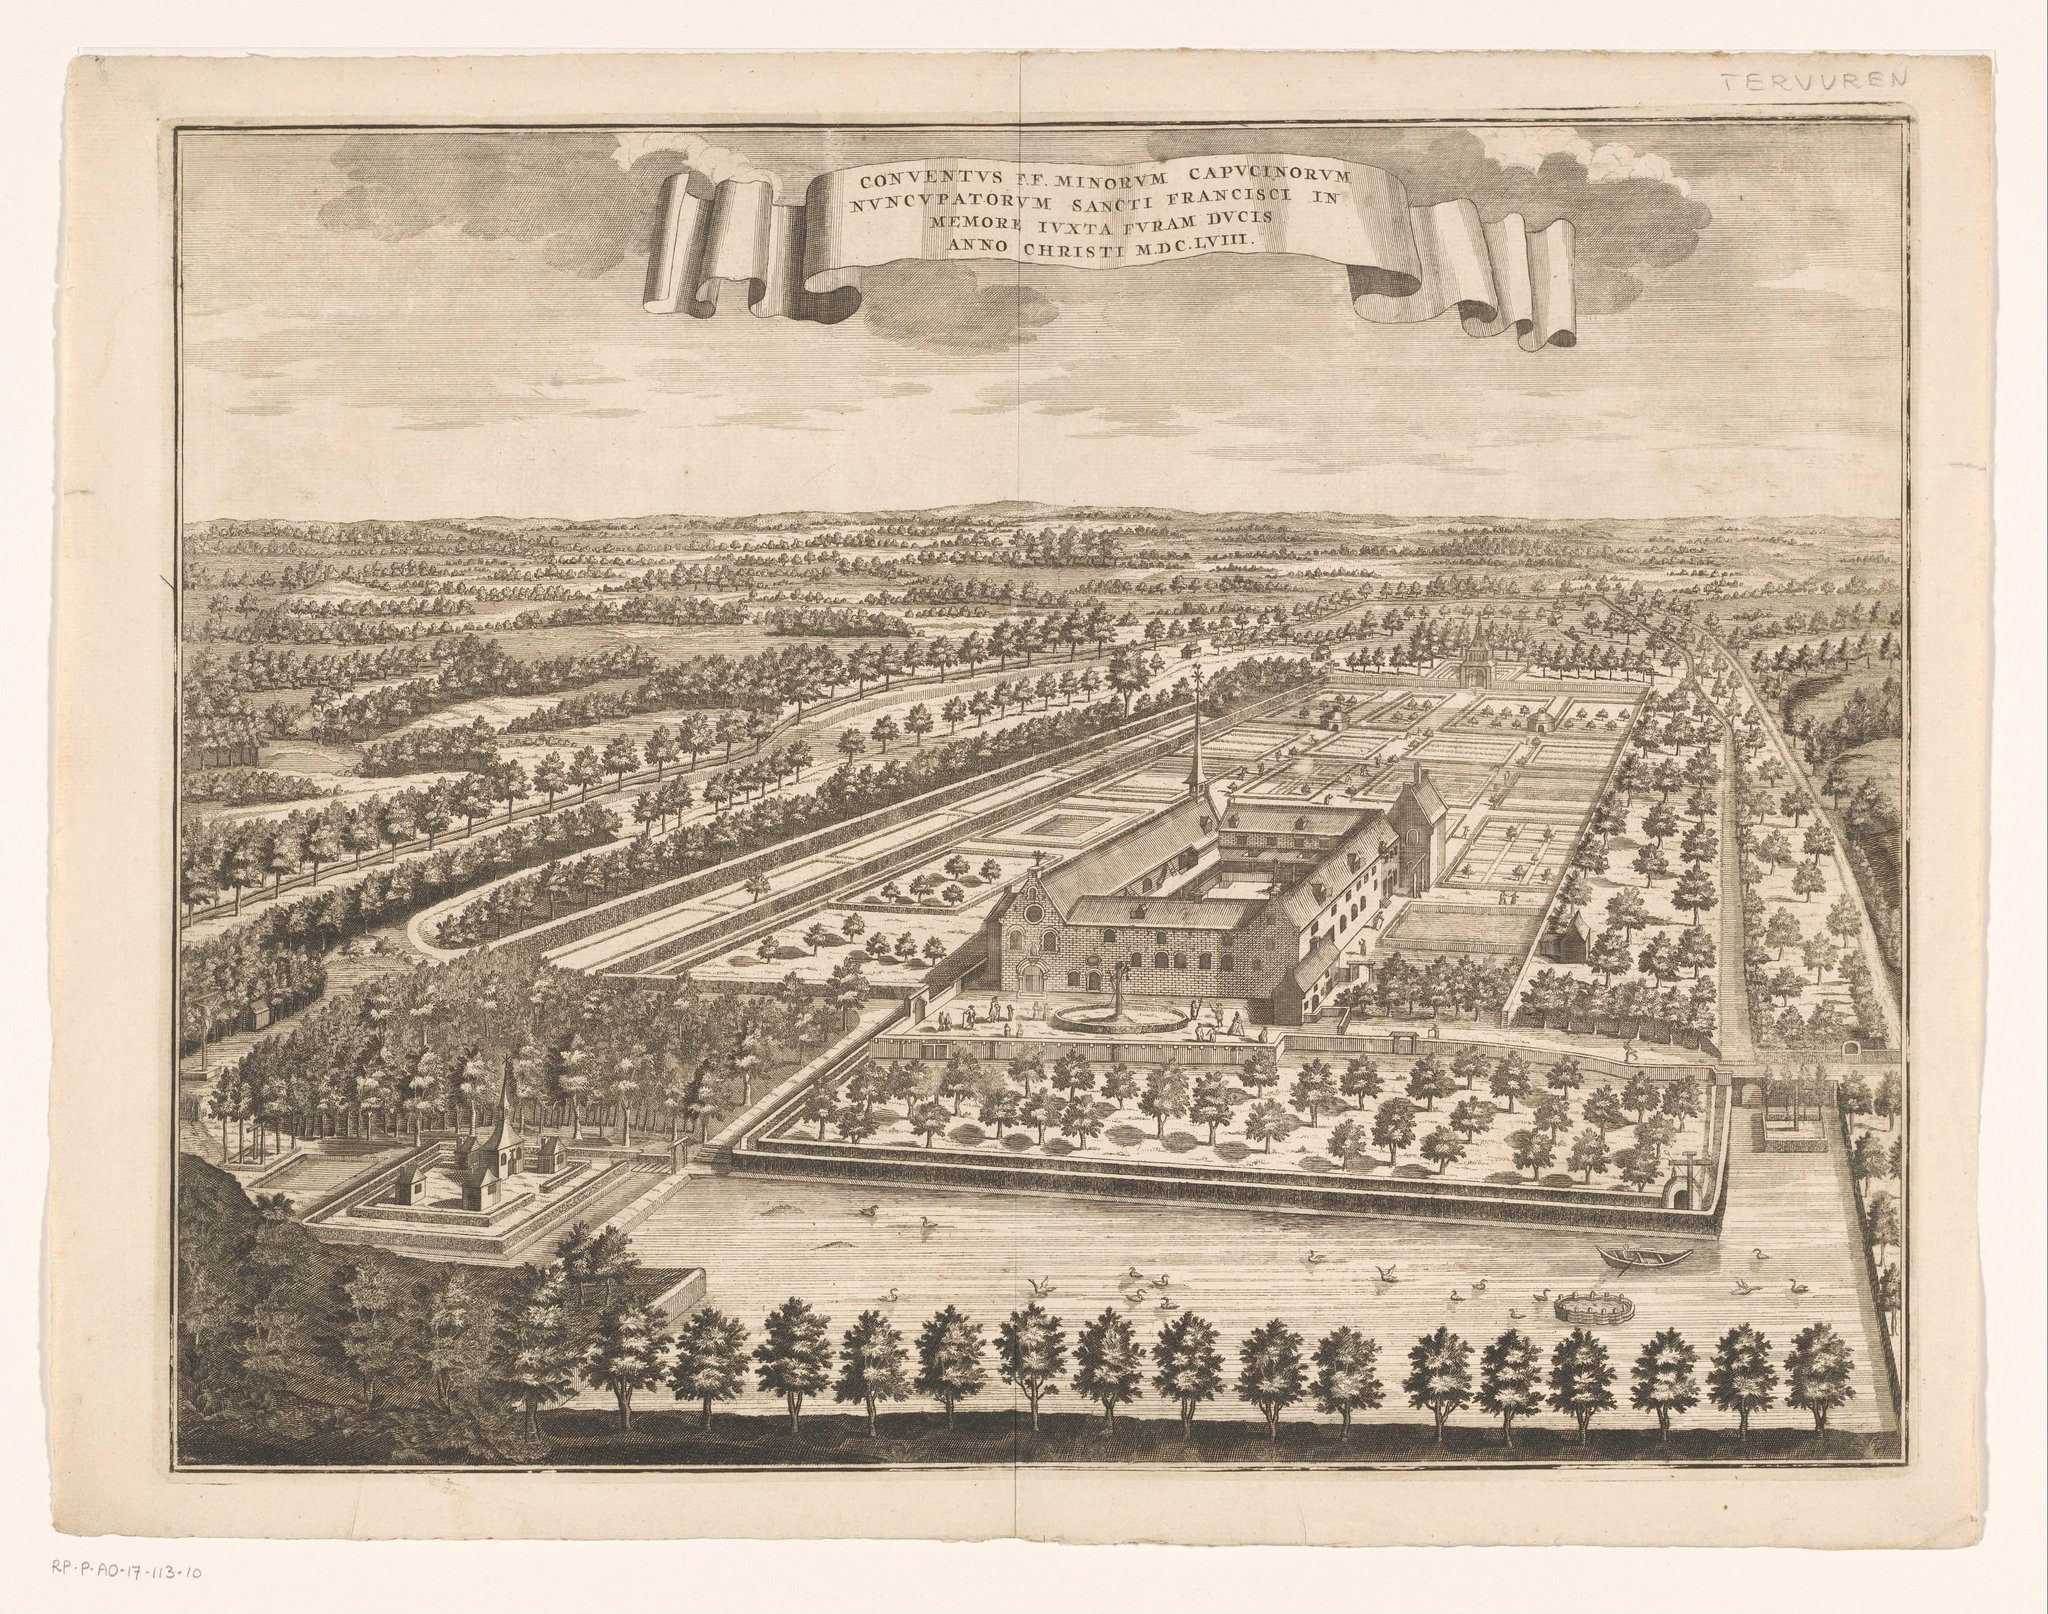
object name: book illustration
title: Gezicht op het kapucijnenklooster te Tervuren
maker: Anonymous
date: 1727-1734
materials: paper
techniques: engraving, etching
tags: birds, rowing-boat, canoe, etc., cloisters ~ monastery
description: Prent ook gebruikt in: Sanderus, Antonius. Groot kerkelyk toneel des Hertogdoms van Brabant (...). Den Haag: Christiaan van Lom, 1727. En in: Sanderus, Antonius. Antonii Sanderi presbyteri Chorographia sacra Brabantiæ. 3 delen. Den Haag: Christiaan van Lom, 1726-1727, dl.3 (1727). En in: Sanderus, Antonius. Le grand theatre sacré du duché de Brabant (...). 4 delen. Den Haag: Gerard Block, 1729-1734.